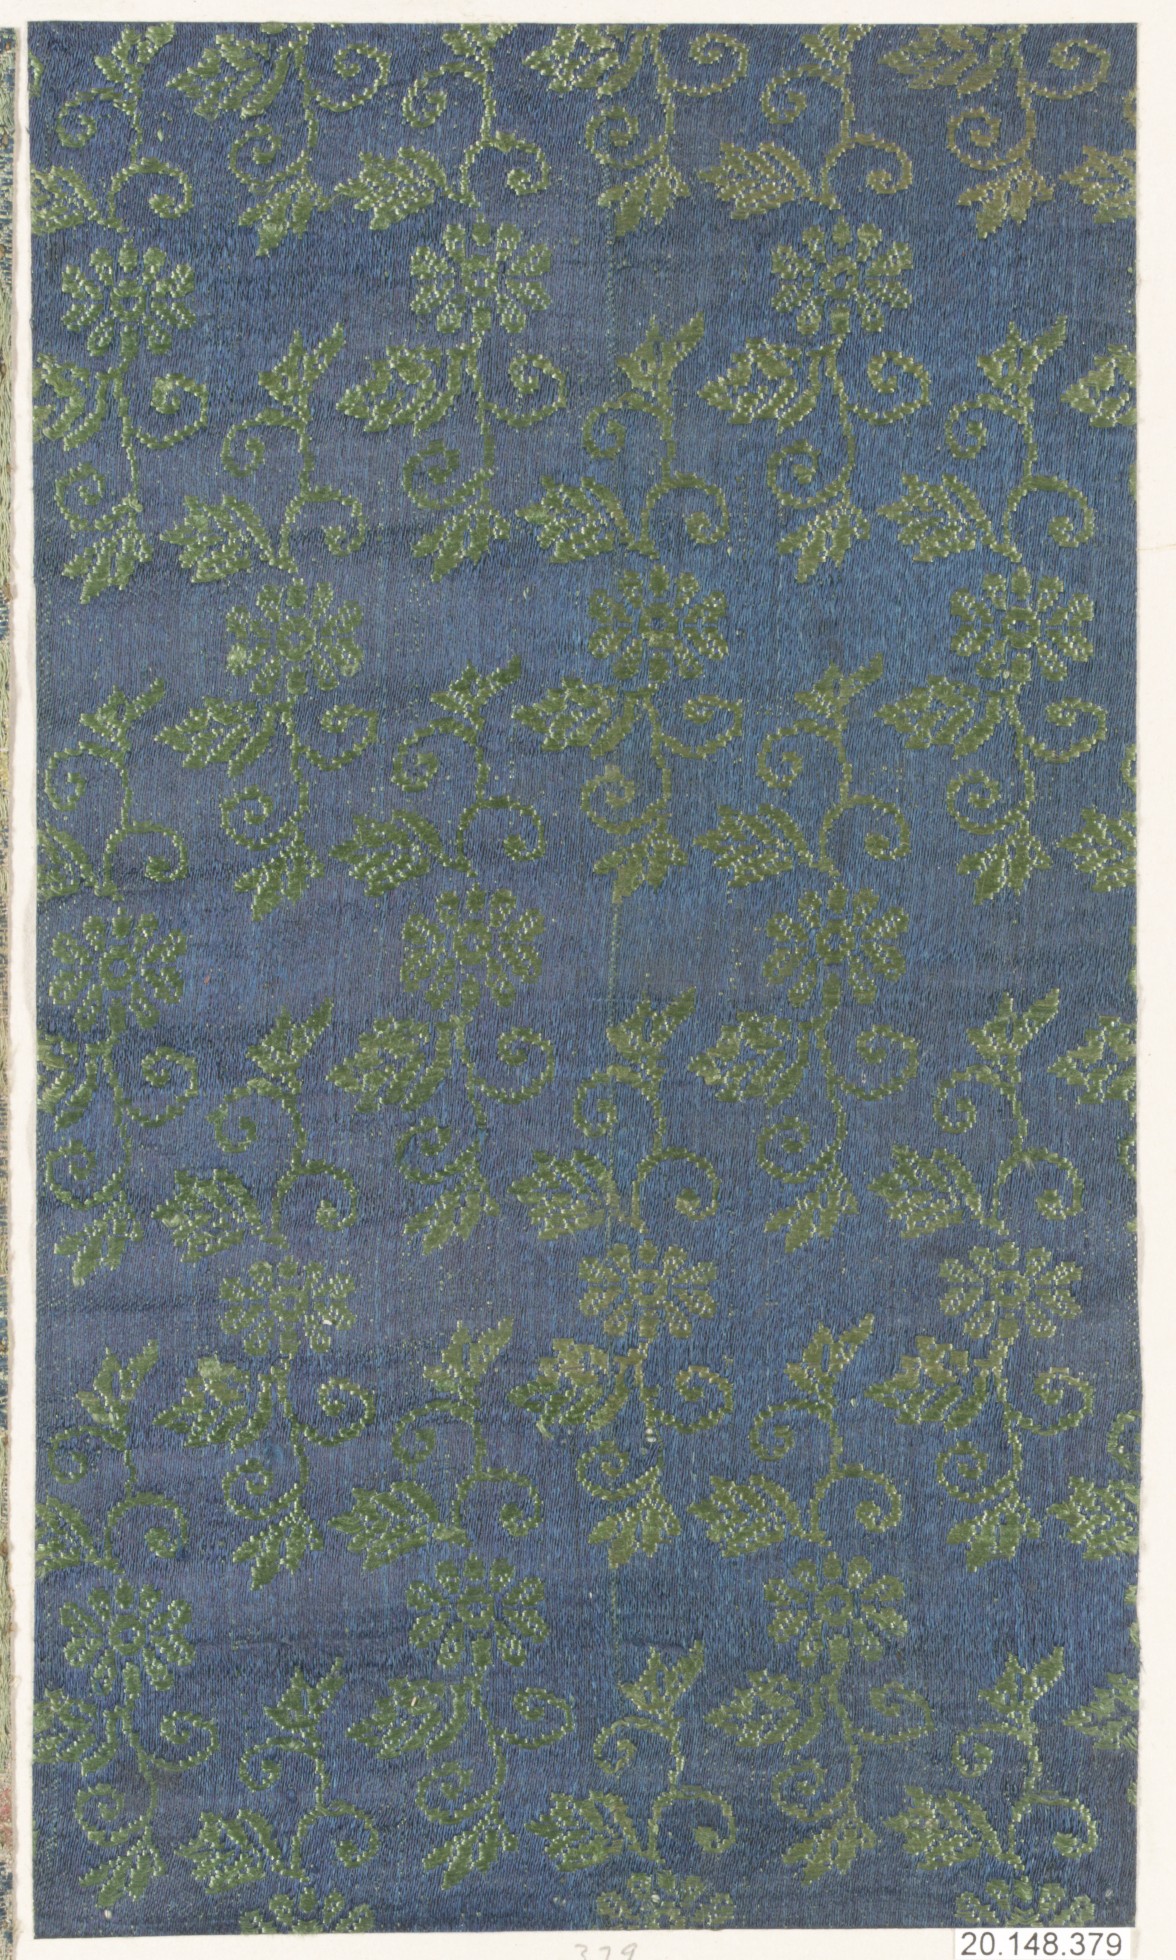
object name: piece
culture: japanese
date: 1701-1800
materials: silk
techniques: compound weave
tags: flowers,leaves